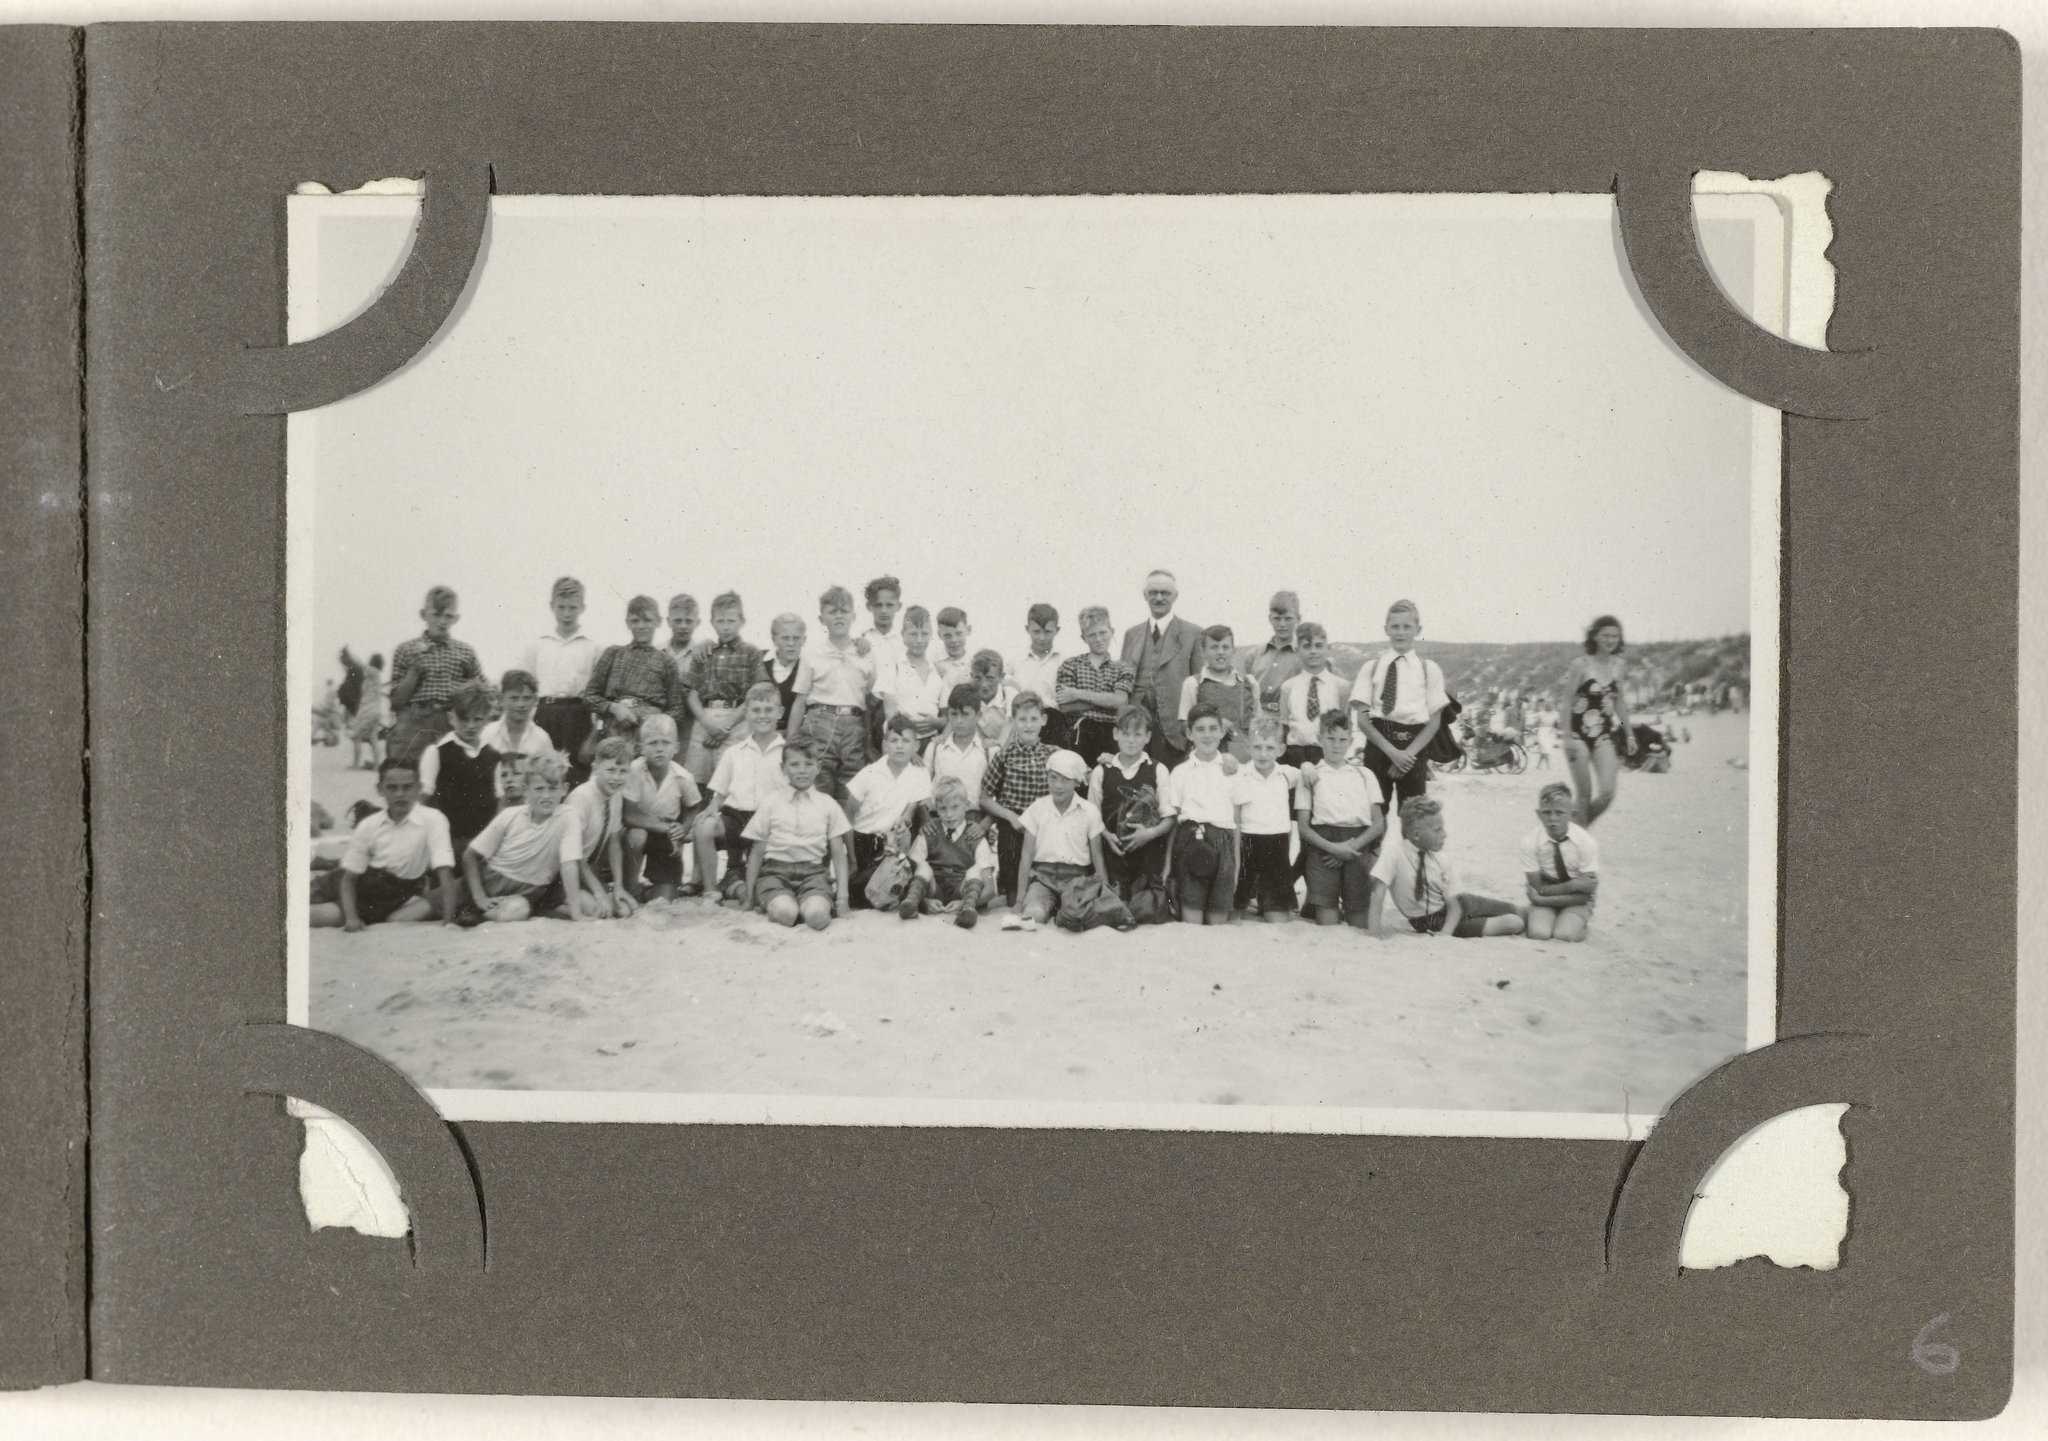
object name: photograph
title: Groepsfoto op het strand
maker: Anonymous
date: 1933-1944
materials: photographic support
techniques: gelatin silver print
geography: rotterdam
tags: wim van den bosch, rotterdam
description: Een groep jongens op het strand. Waarschijnlijk een schoolklas met leraar. Onderdeel van het familiealbum 1933-1944.